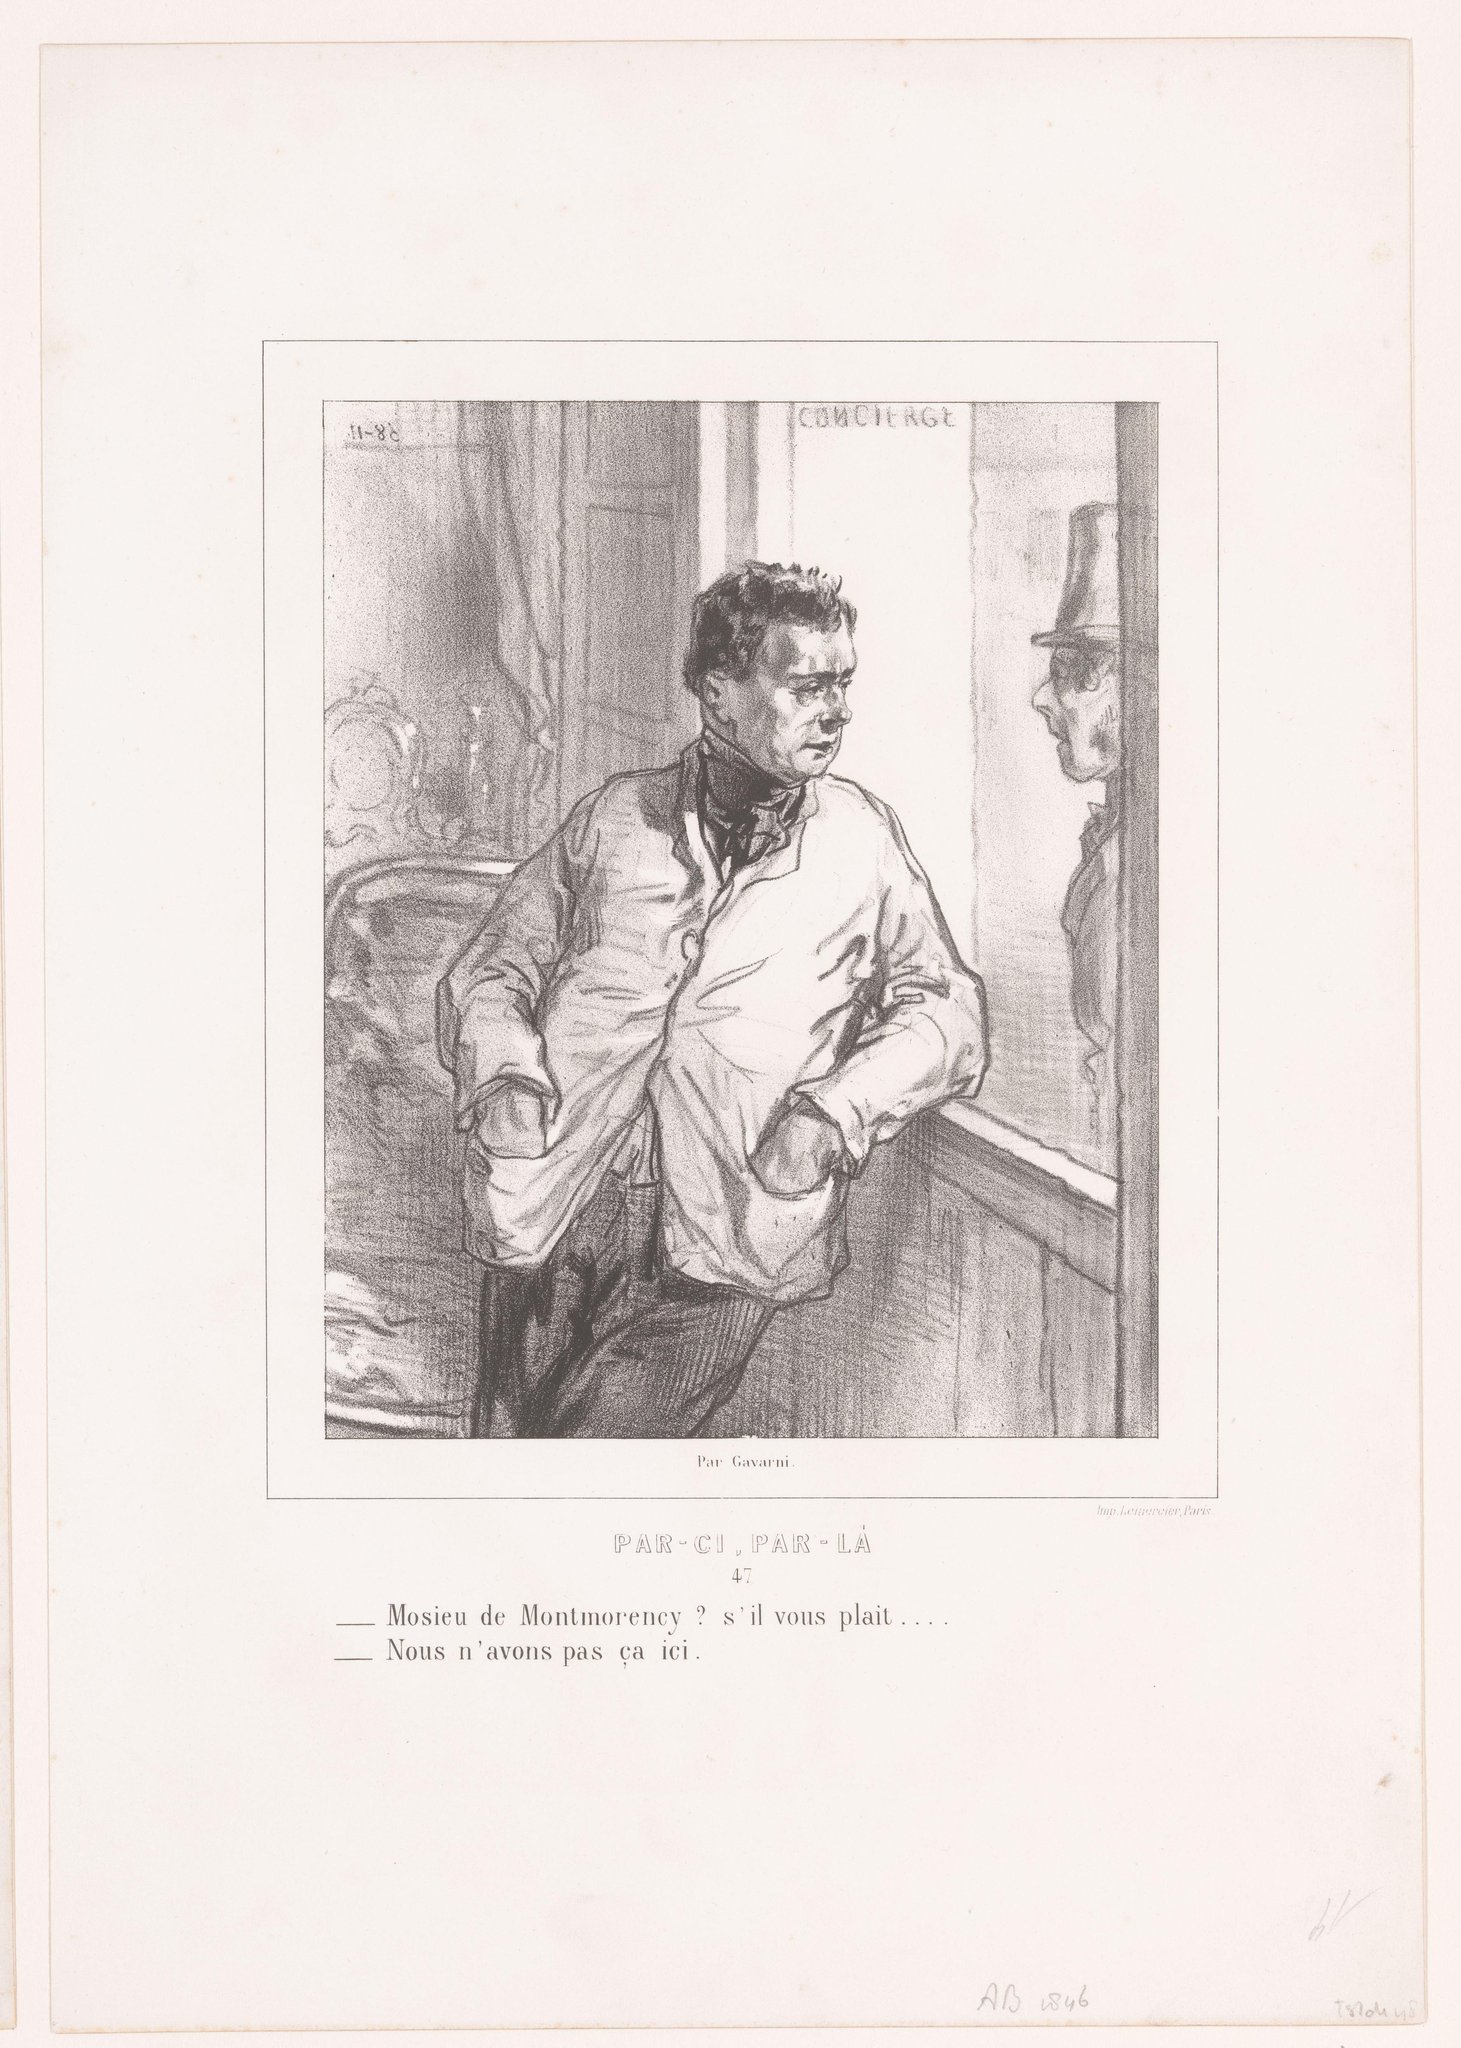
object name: cartoon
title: Hier en daar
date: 1857-1858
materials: paper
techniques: lithograph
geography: paris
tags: house-guard, doorkeeper, janitor, conversation, dialogue; conversation piece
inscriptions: collector's mark: Lugt 2228a